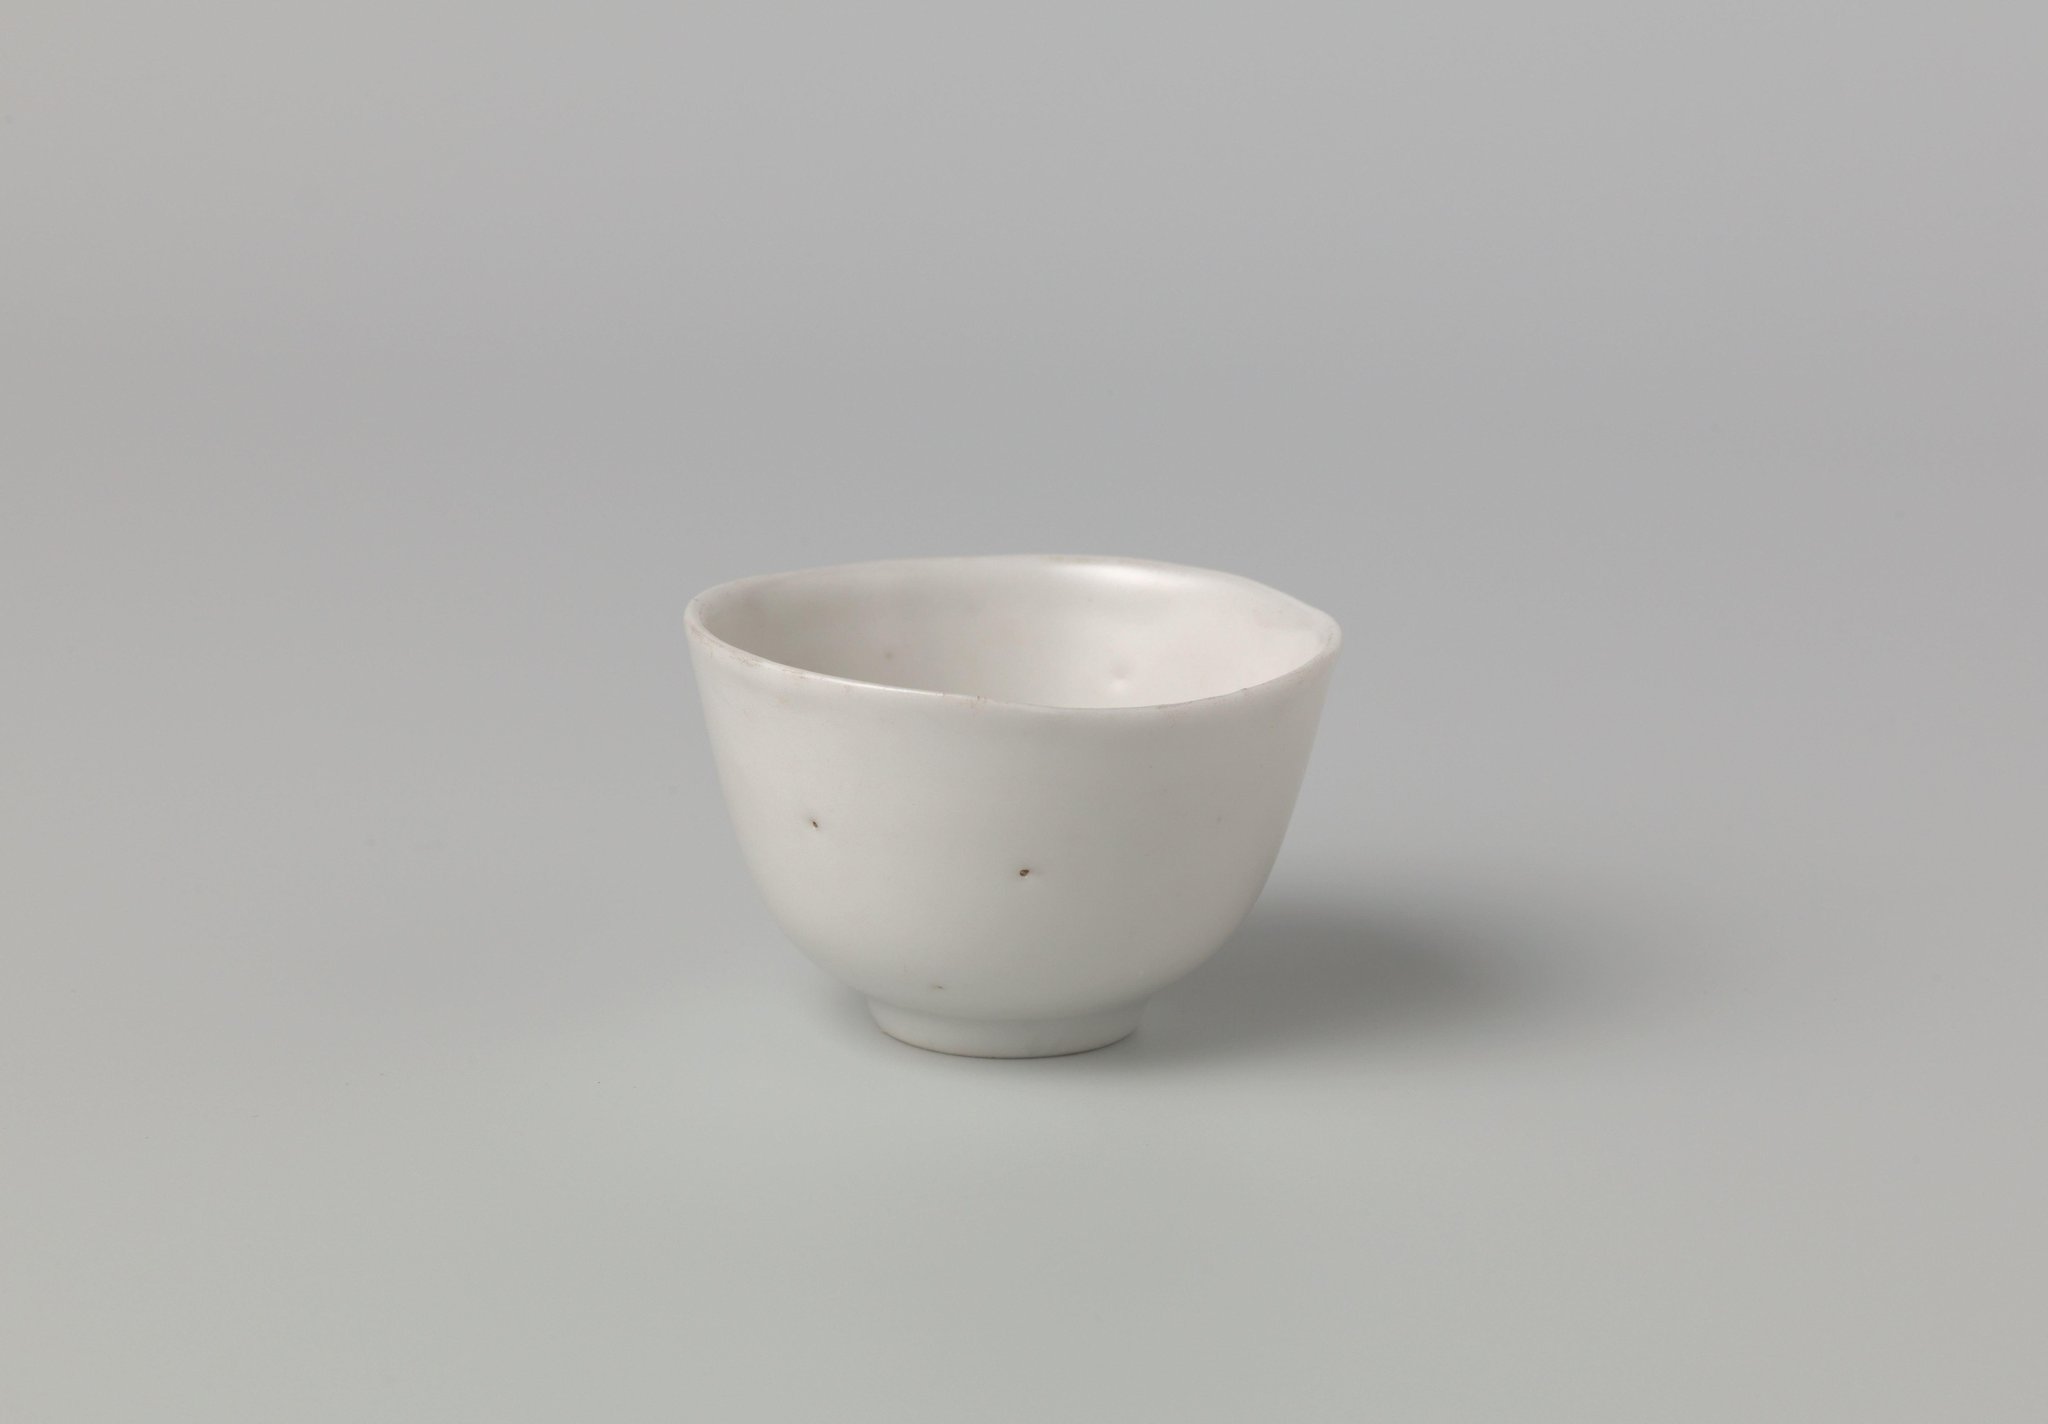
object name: bowl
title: Bowl with a white glaze and irregular rim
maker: Anonymous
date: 1600-1699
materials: cobalt, glaze, porcelain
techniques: firing, turning, vitrification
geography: south china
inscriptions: mark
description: Klokvormige kom van porselein, bedekt met een wit glazuur. Op de bodem een ongeglazuurde band. Gemerkt op de onderzijde met een ongeïdentificeerd zegelmerk. Wit porselein.